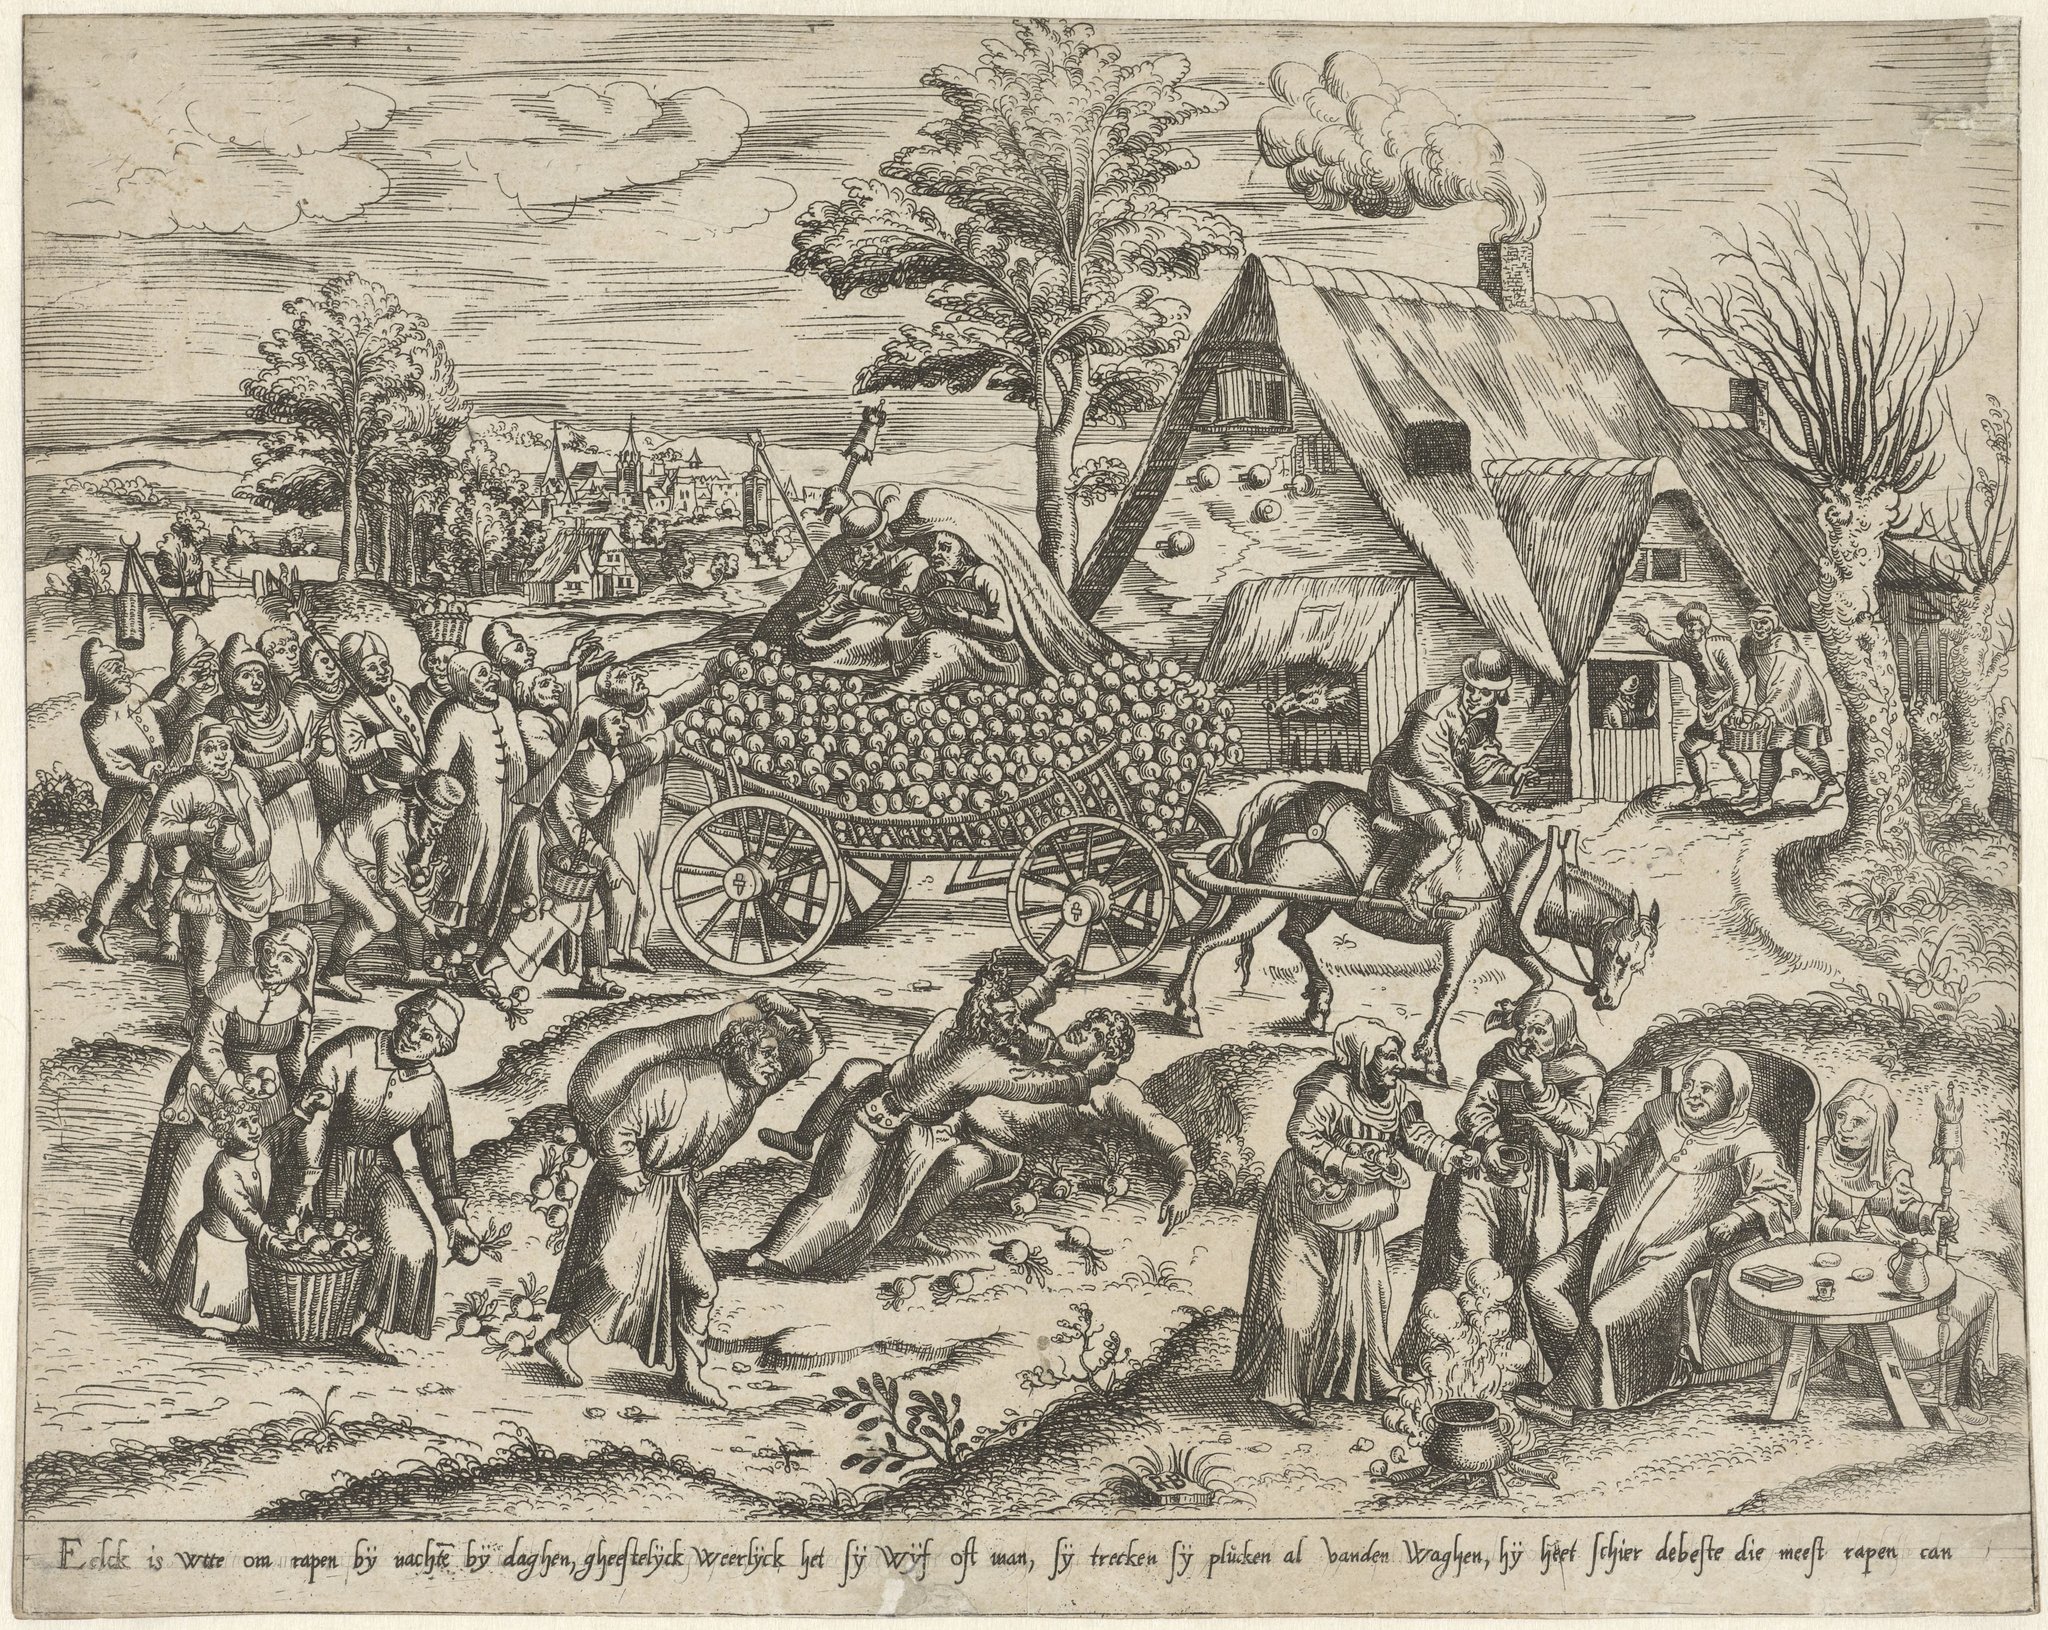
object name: print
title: Allegorie op de hebzucht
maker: remigius hogenberg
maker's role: print maker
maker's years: 1536-1587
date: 1546-1588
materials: paper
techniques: etching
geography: southern netherlands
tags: organization, functionaries and dignitaries in roman catholic church; clergy in general, reaping, picking, mowing ~ harvest, (farm) wagon, freight wagon, cart, instrumental popular music - cc - out of doors, (non-fruit) products of plants or trees: turnip, use of property (opposing concepts) (+ situation or event (especially in genre-painting) with symbolical connotation)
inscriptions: collector's mark: Lugt 2228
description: Op een boerenkar vol met knollen of rapen zitten een man en vrouw muziek te maken. Achter de kar een stoet mannen en vrouwen die proberen zoveel mogelijk rapen te bemachtigen. In het midden op de voorgrond twee vechtende mannen. Rechts op de vooorgrond wordt een geestelijke de knollen aangeboden. Allegorie op de hebbberigheid.